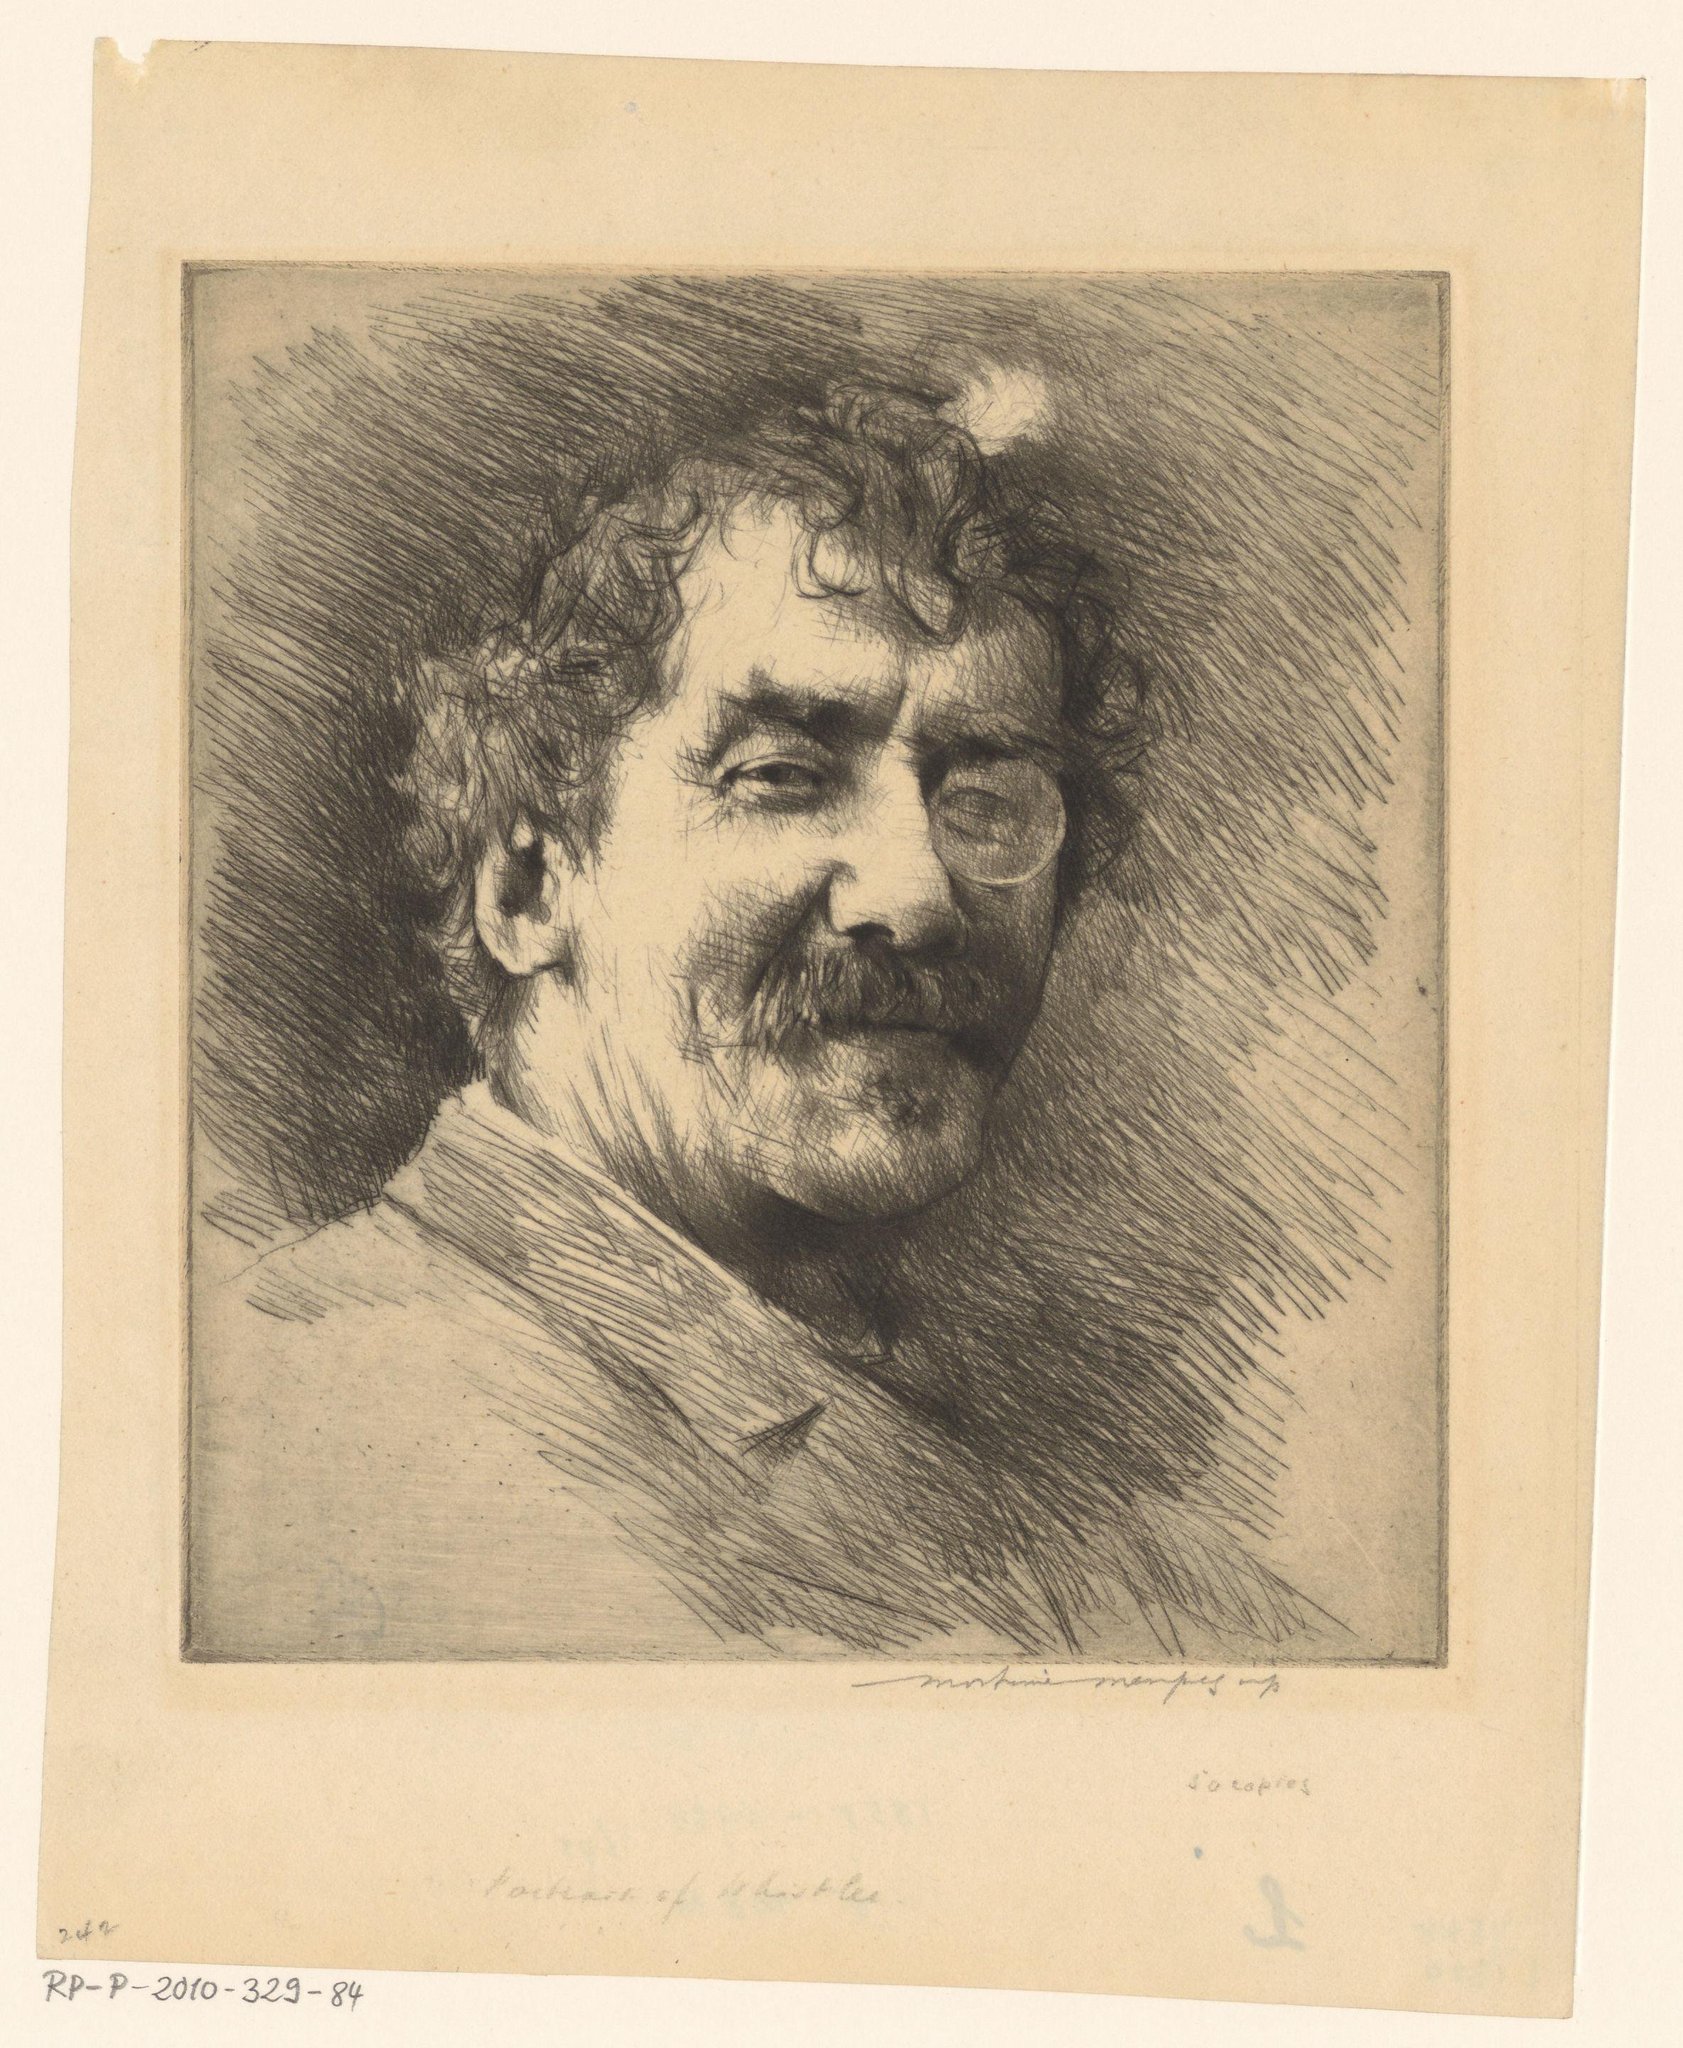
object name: print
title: Portrait of Whistler No. 9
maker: mortimer l. menpes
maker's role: print maker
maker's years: 1855-1938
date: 1912-1913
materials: paper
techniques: drypoint, etching, intaglio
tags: painter, print maker, james abbott mcneill whistler, monocle, single lorgnette, historical persons, portrait, self-portrait of painter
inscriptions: signature: ‘Mortimer Menpes’, collector's mark: Lugt 4731, collector's mark: Lugt 2228, stamp: ‘L’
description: Buste naar rechts, met monocle, de beschouwer aankijkend.